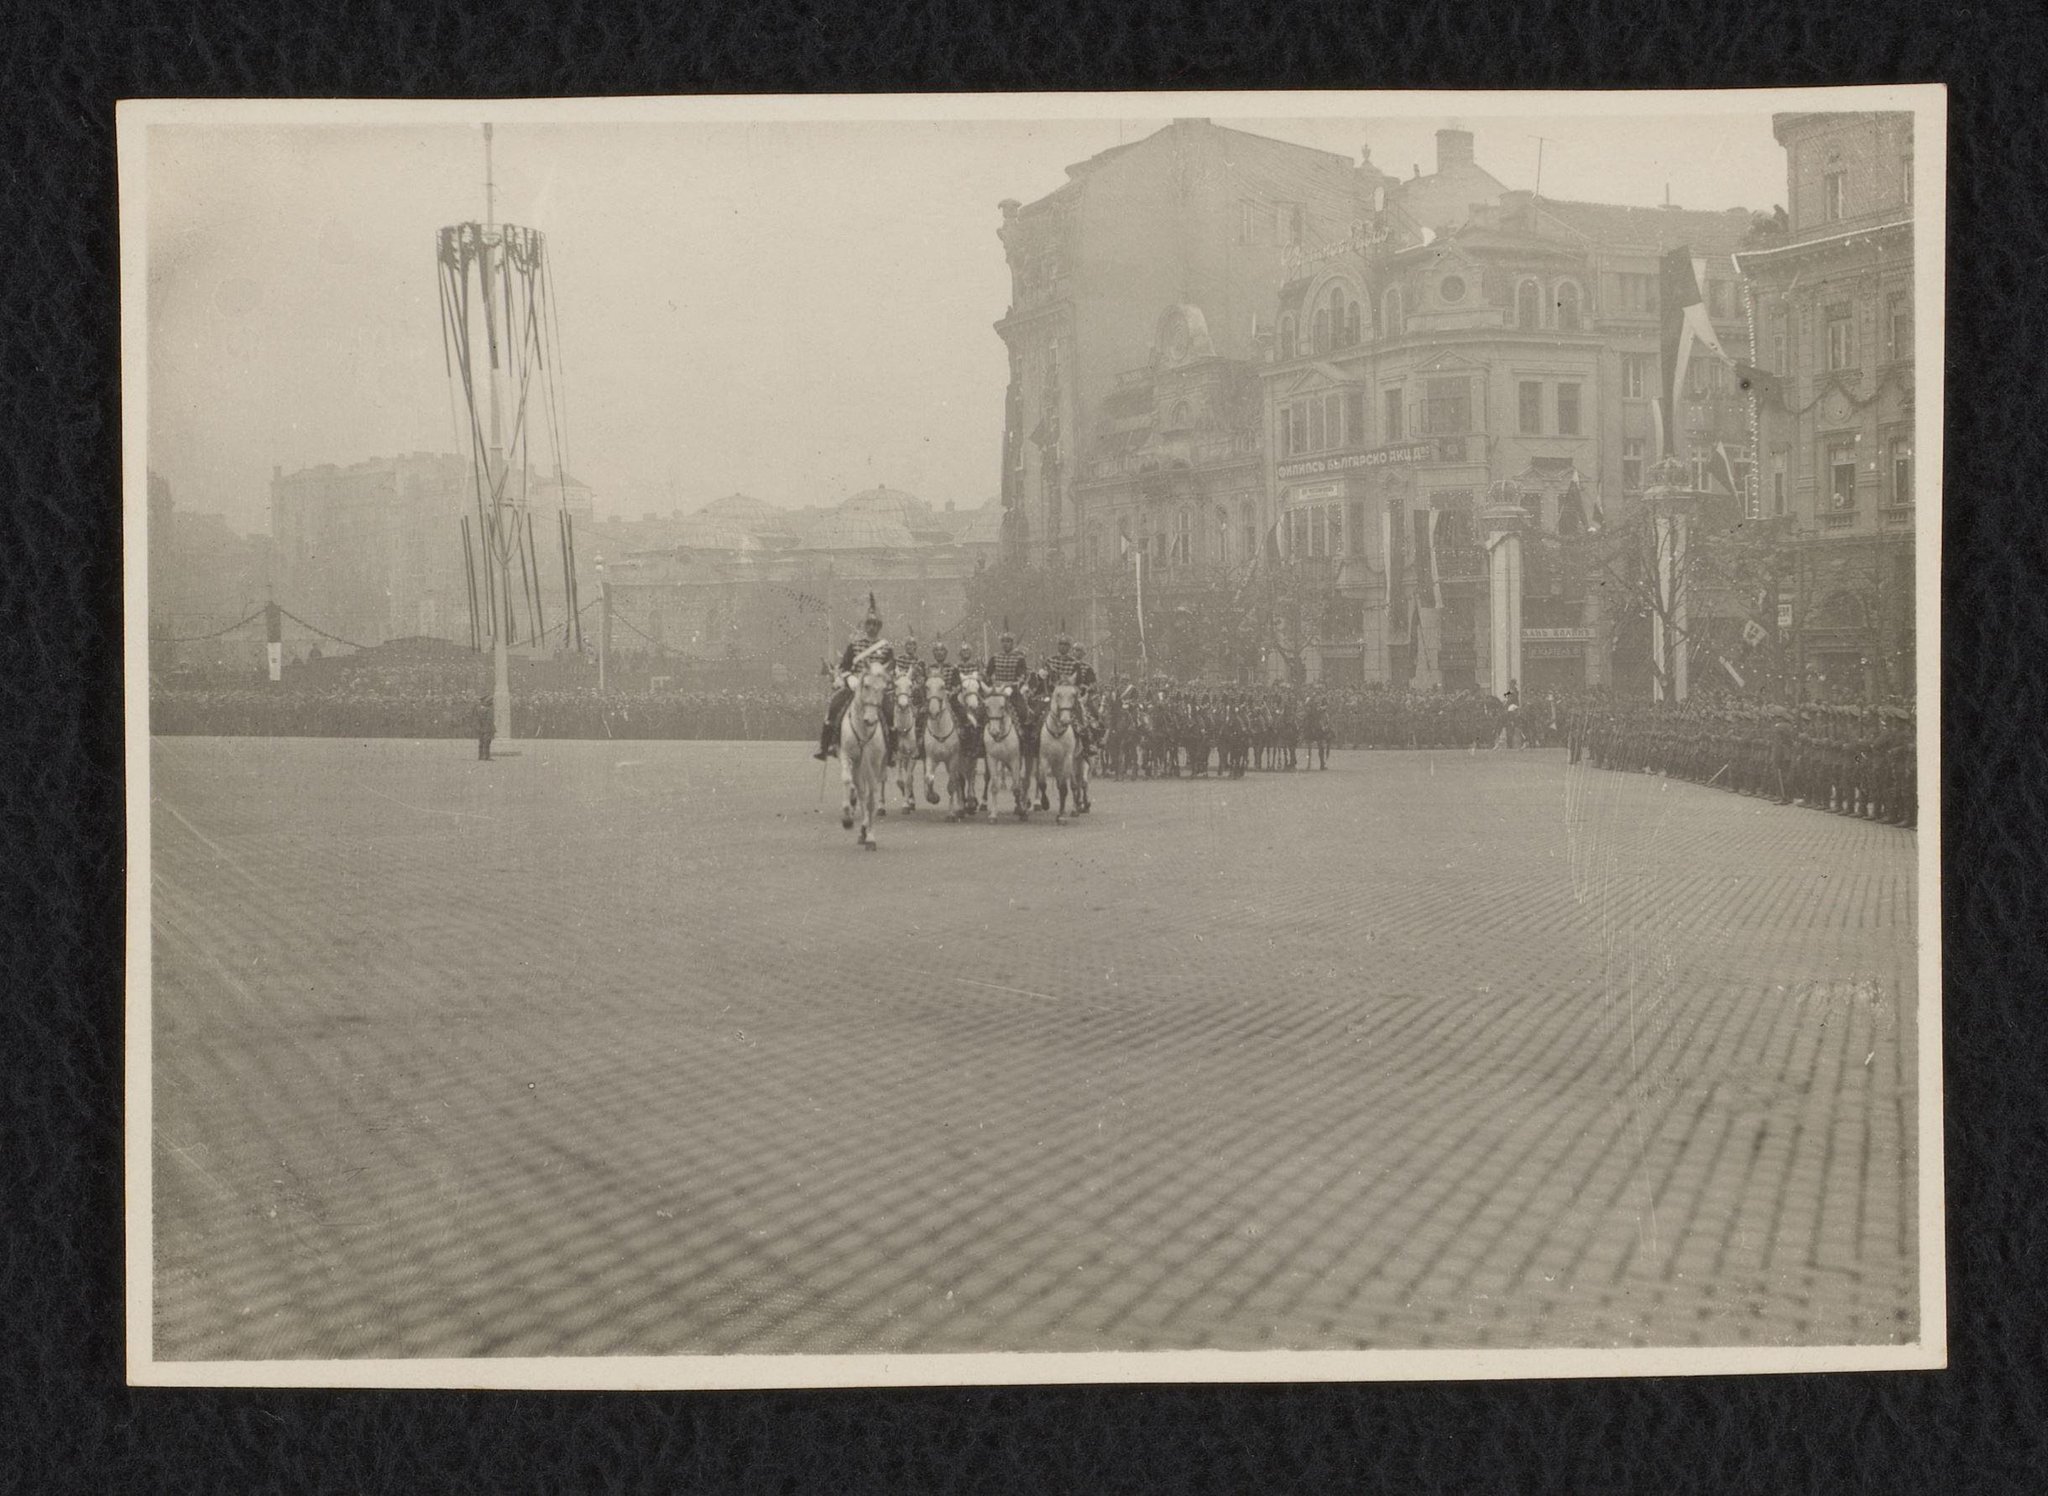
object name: photograph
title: Erewacht op het plein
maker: Anonymous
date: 1930-1935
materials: photographic support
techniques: gelatin silver print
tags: square, place, circus, etc., public festivities at marriage of royal persons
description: Militaire erewacht te paard op een groot open plein in een stad. Waarschijnlijk in afwachting van het rijtuig met het vorstelijk paar (zie gerelateerde foto). De gebouwen aan het plein dragen opschriften in een cyrillisch schrift. Losse foto achterin het fotoalbum met vakantiefoto's (van augustus 1932 tot augustus 1935).